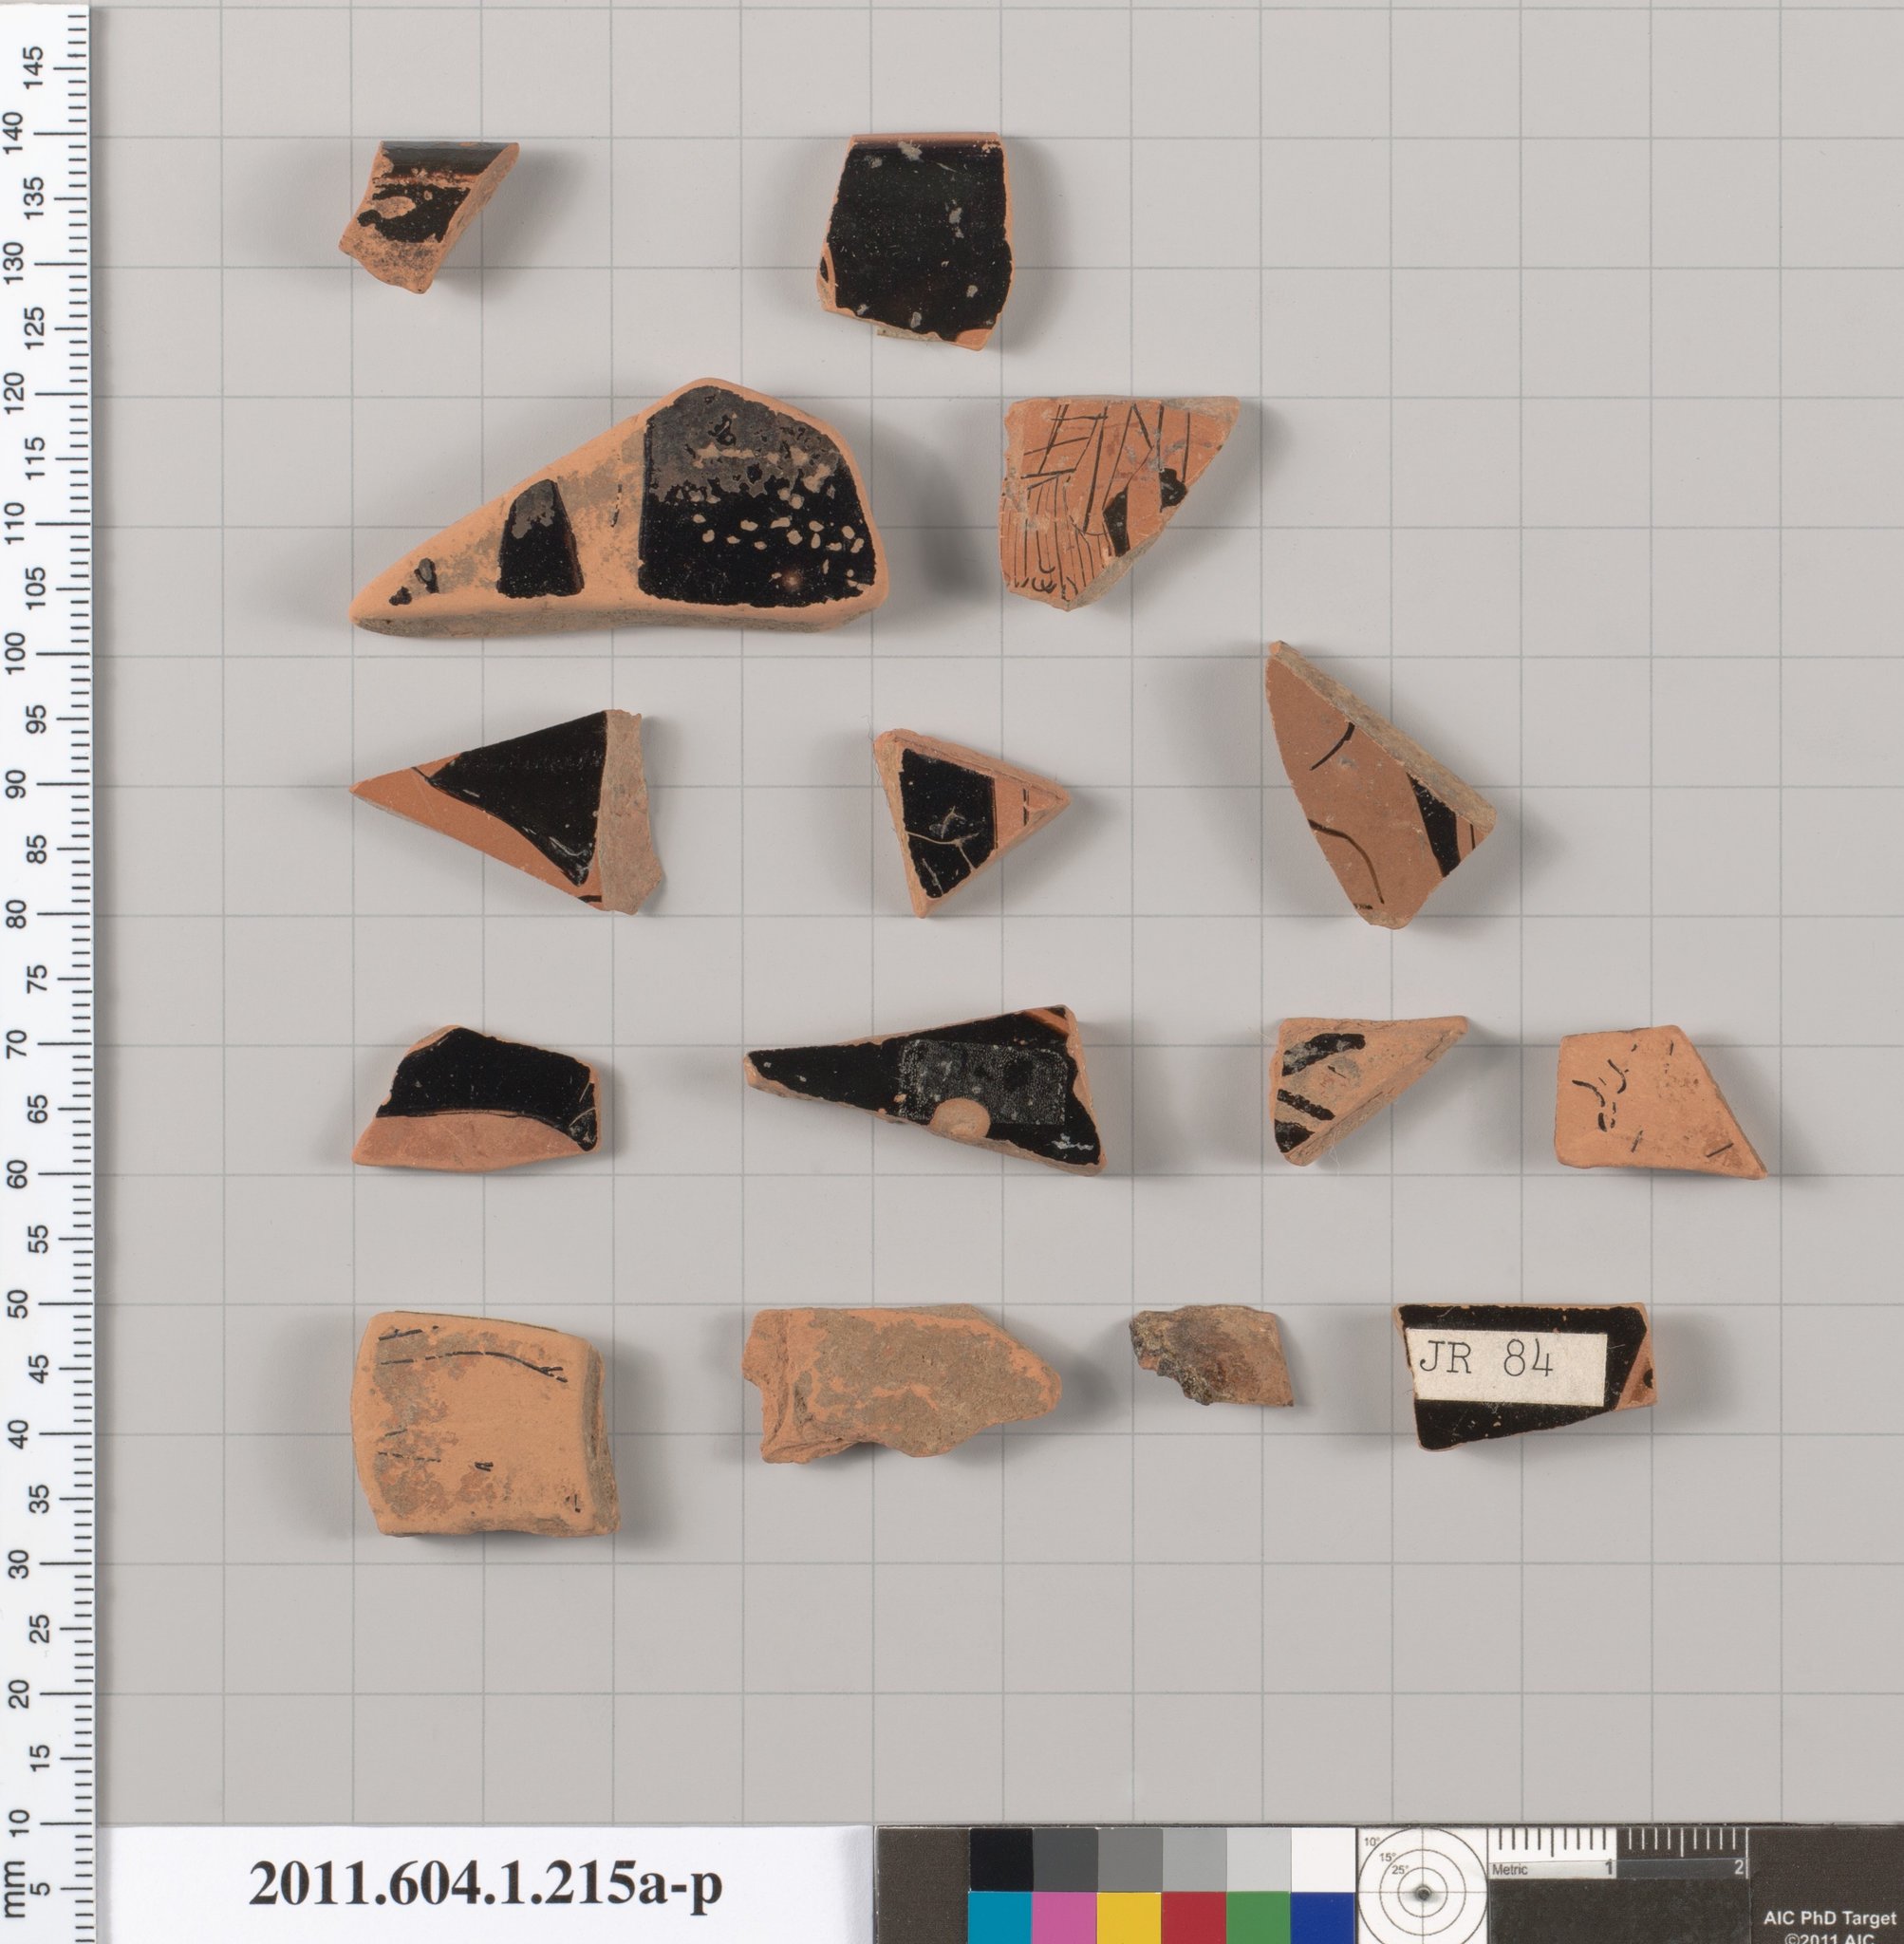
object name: kylix fragment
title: Terracotta fragments of a kylix (drinking cup)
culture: greek, attic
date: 475-451 BCE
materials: terracotta